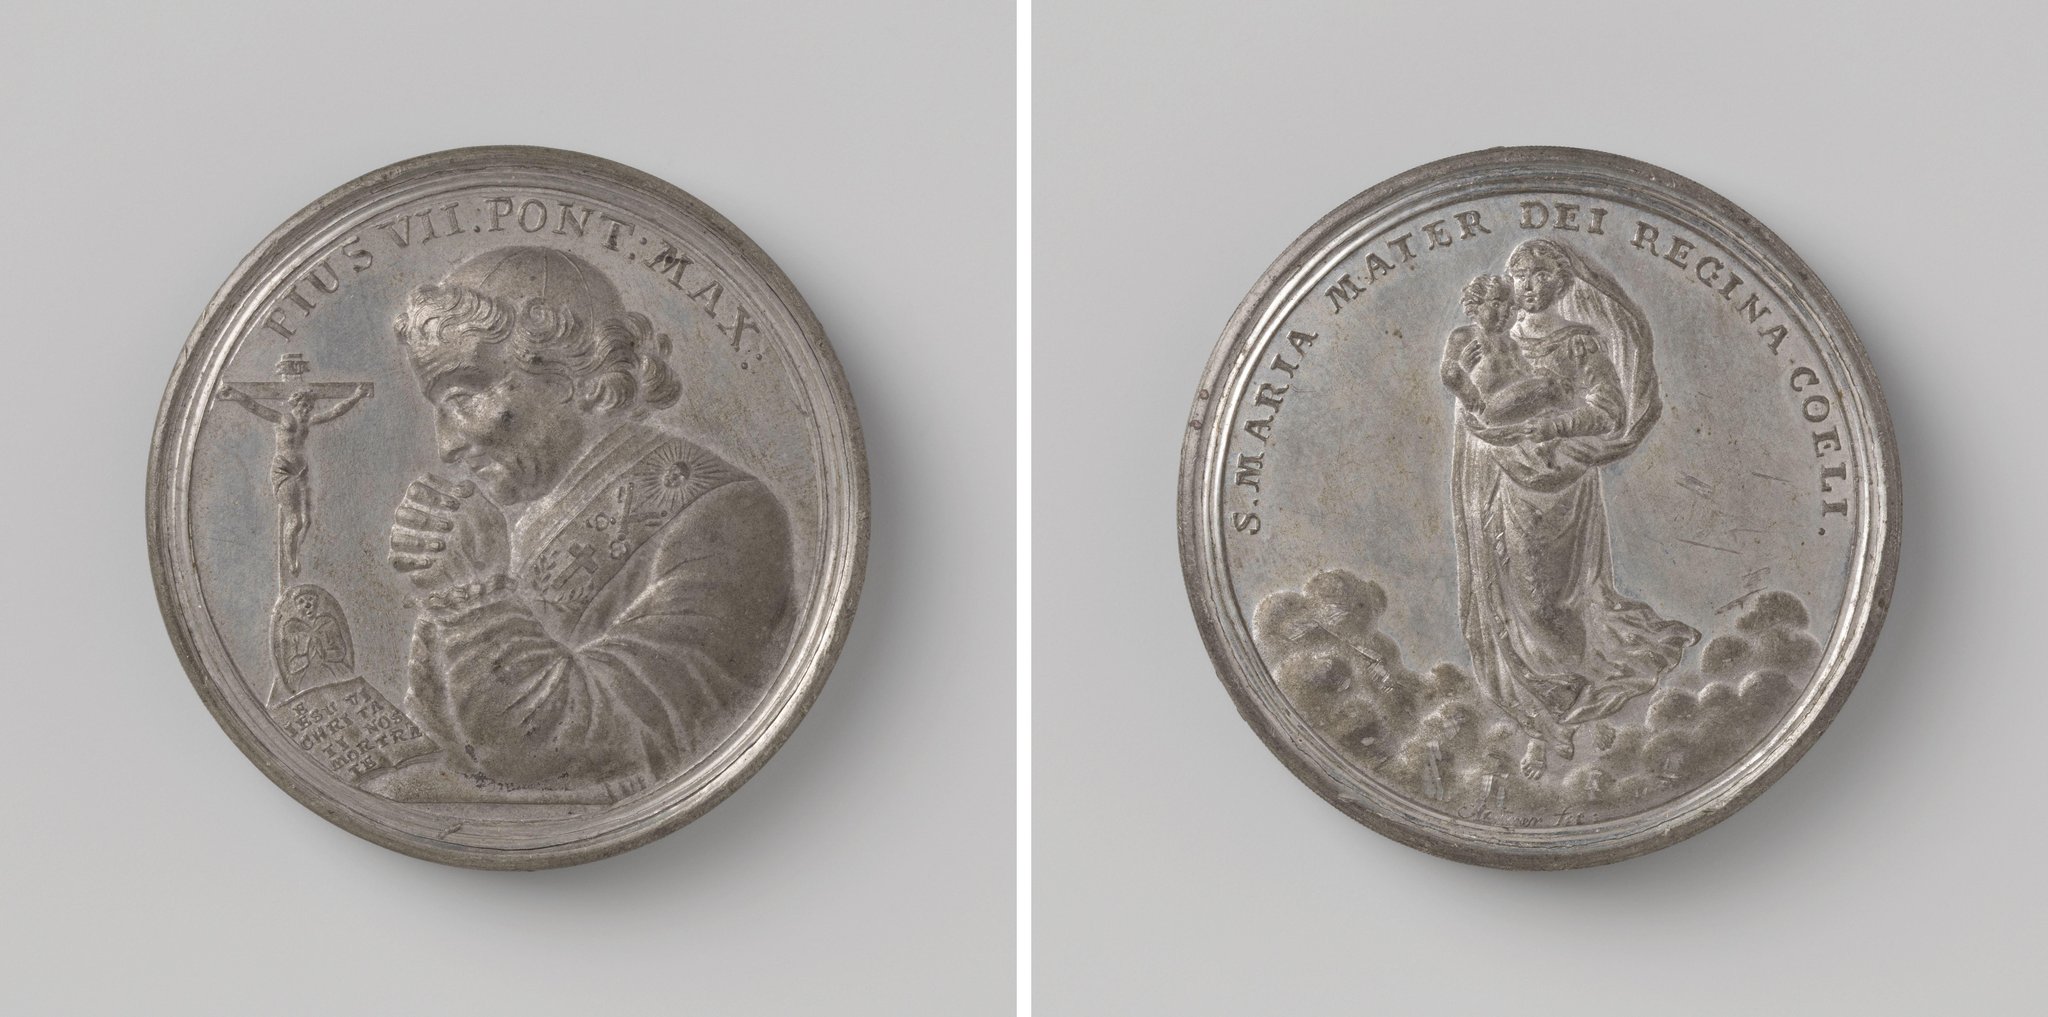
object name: history medal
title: Overlijden van paus Pius VII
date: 1823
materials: paper, silver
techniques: printing, striking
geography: nuremberg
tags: rome, clergyman, pius vii